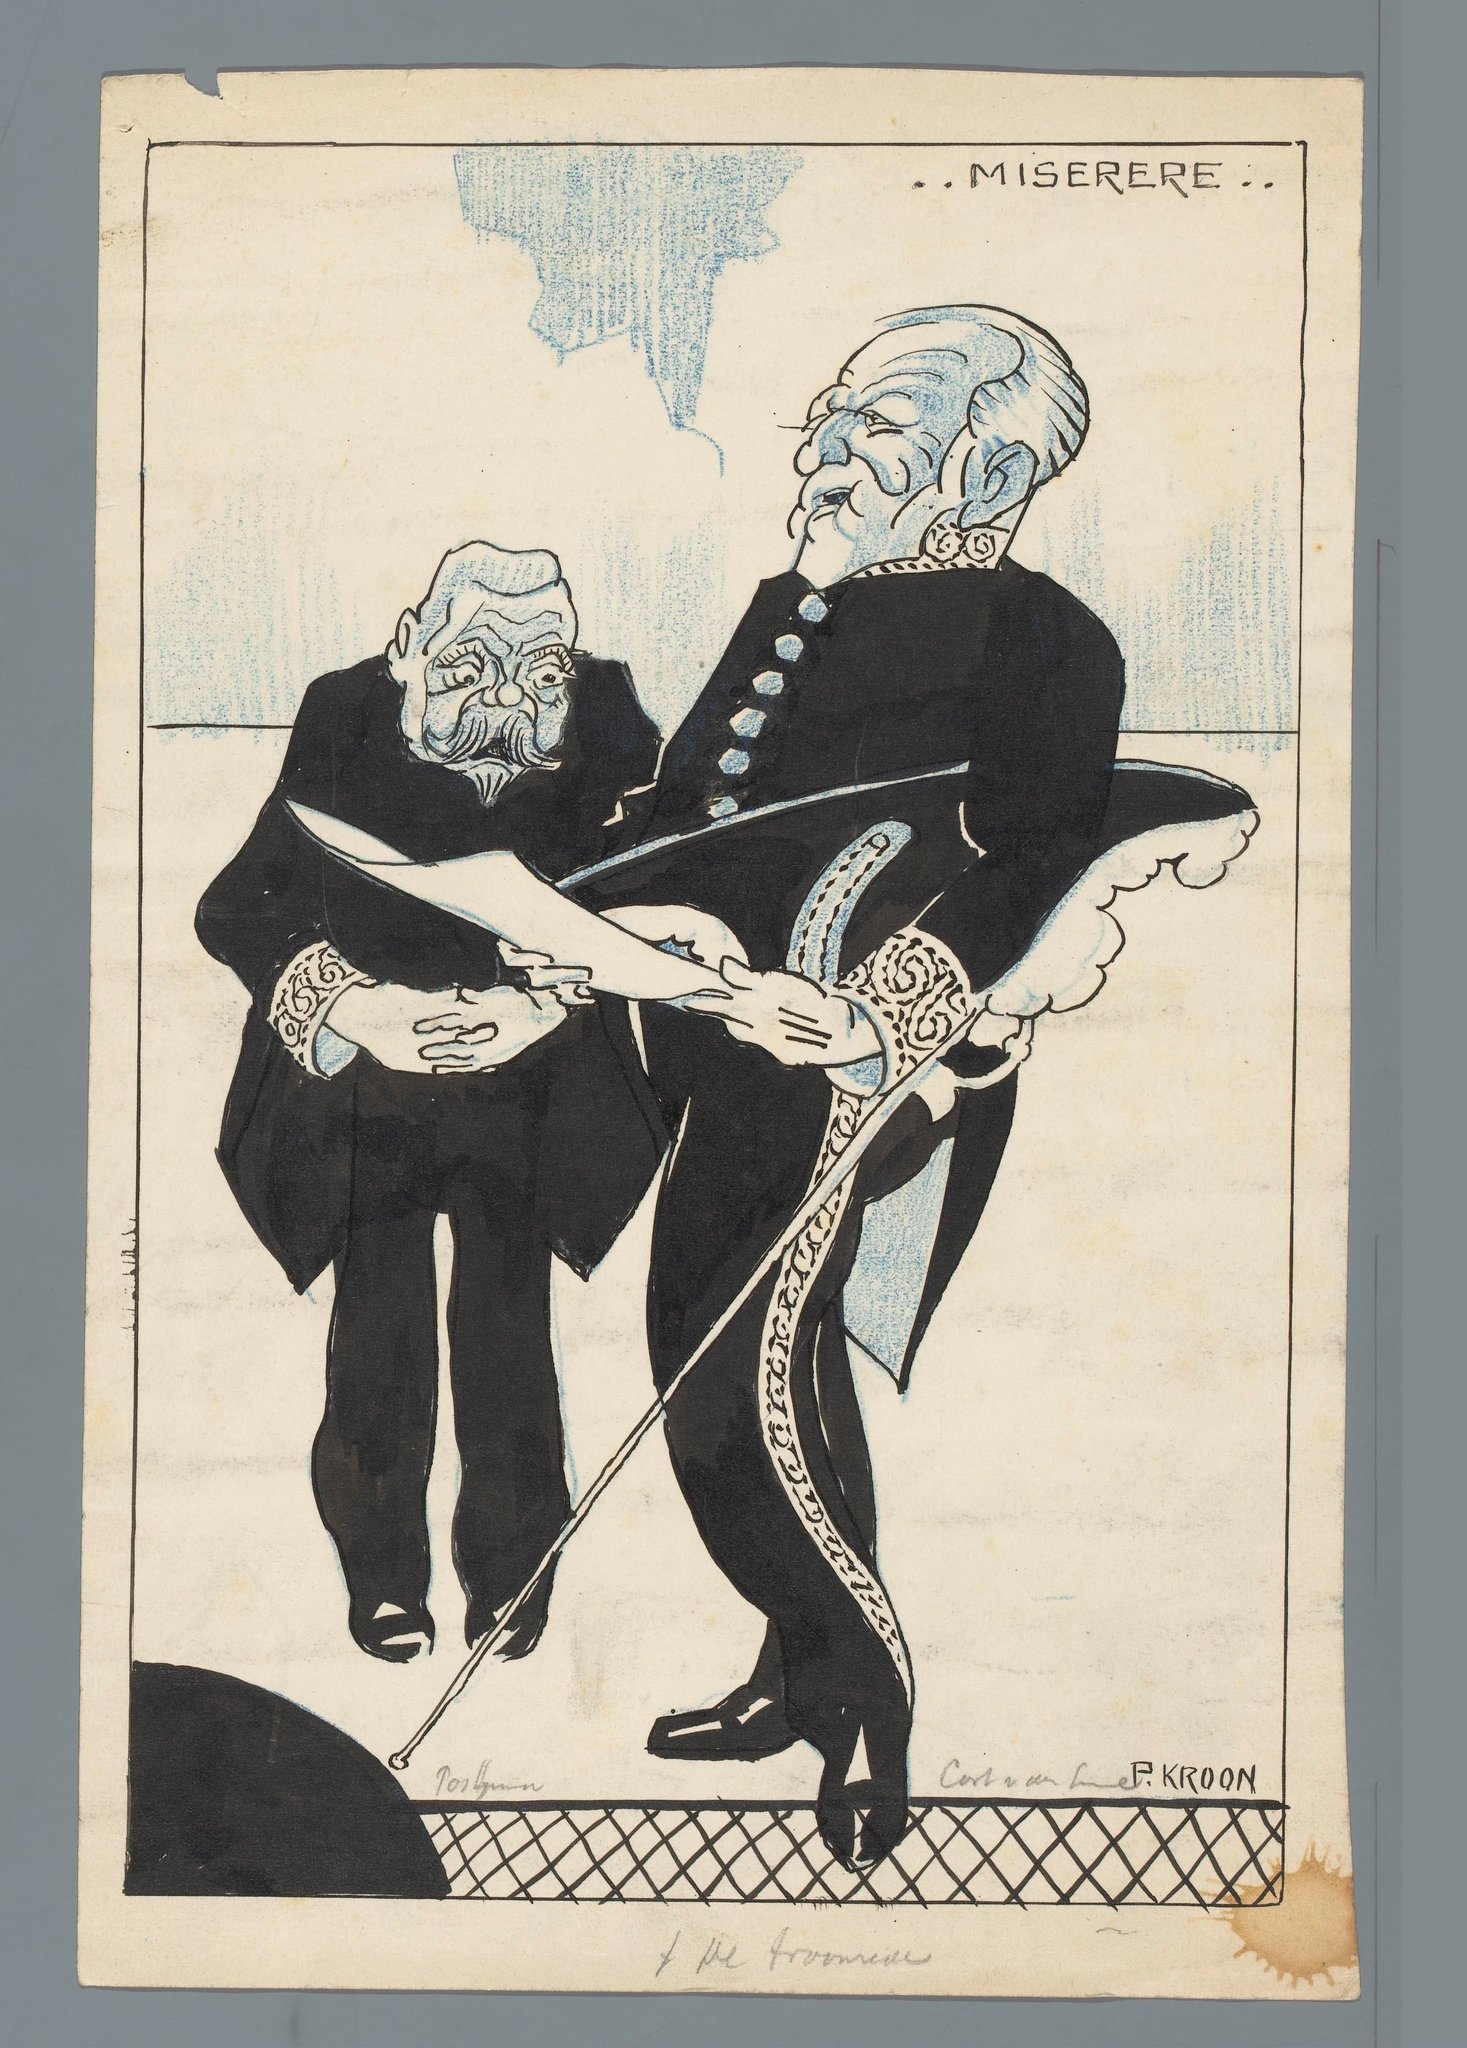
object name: drawing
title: De troonrede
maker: patricq kroon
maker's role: draughtsman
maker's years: 1862-1941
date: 1915-1930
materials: ink, paper, pencil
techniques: brush, pen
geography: netherlands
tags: politician, minister ~ government, political caricatures and satires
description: Ministers Posthuma en Cort van der Linden met de troonrede. Ontwerp voor een politieke spotprent.